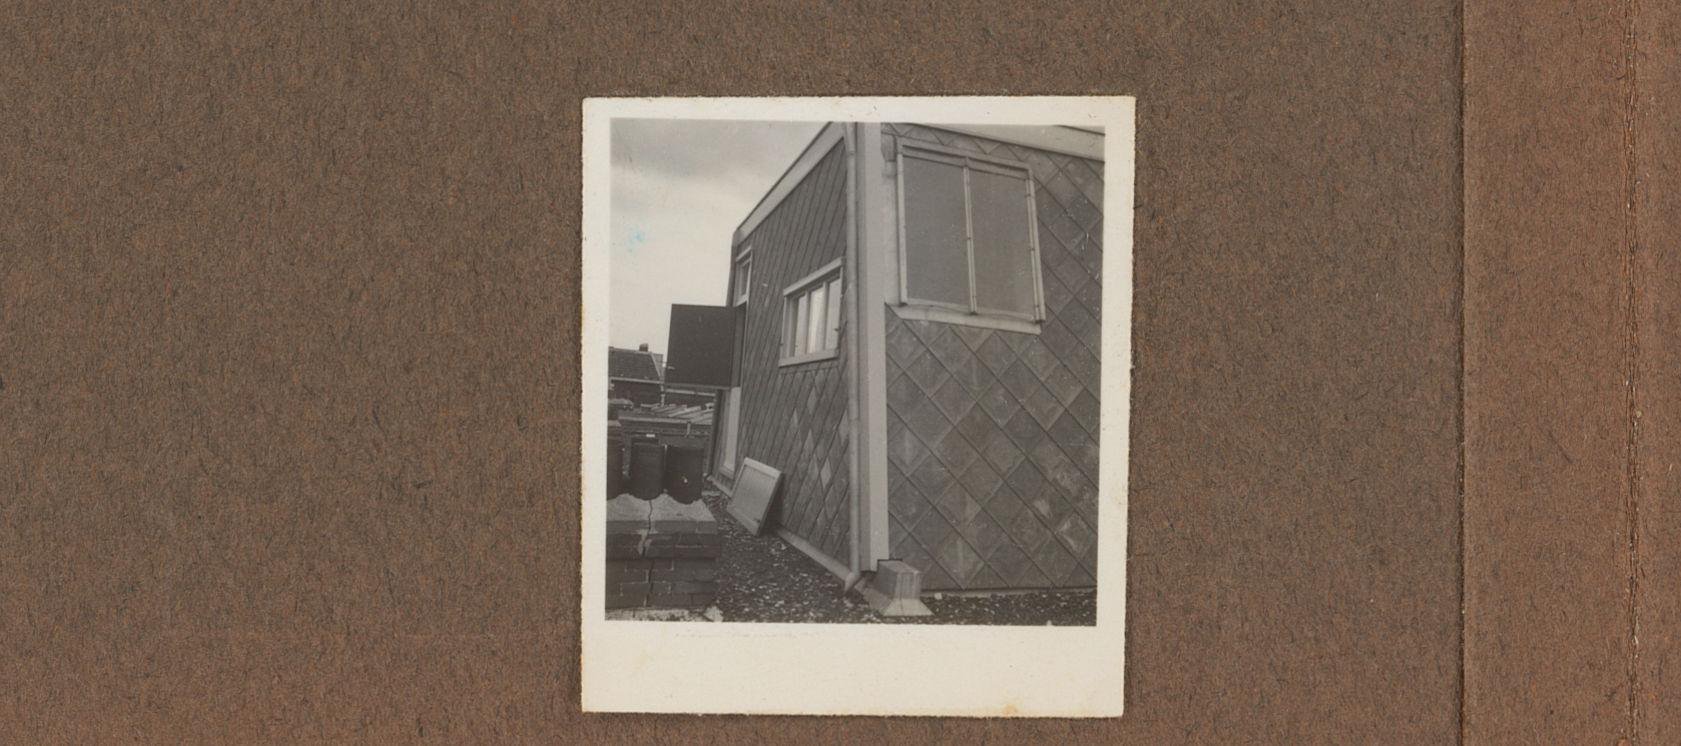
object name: photograph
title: Dak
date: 1900-1920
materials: photographic support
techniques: photography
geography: netherlands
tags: amsterdam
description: Foto op bruin albumblad 56 van familiealbum van Alphons Diepenbrock.